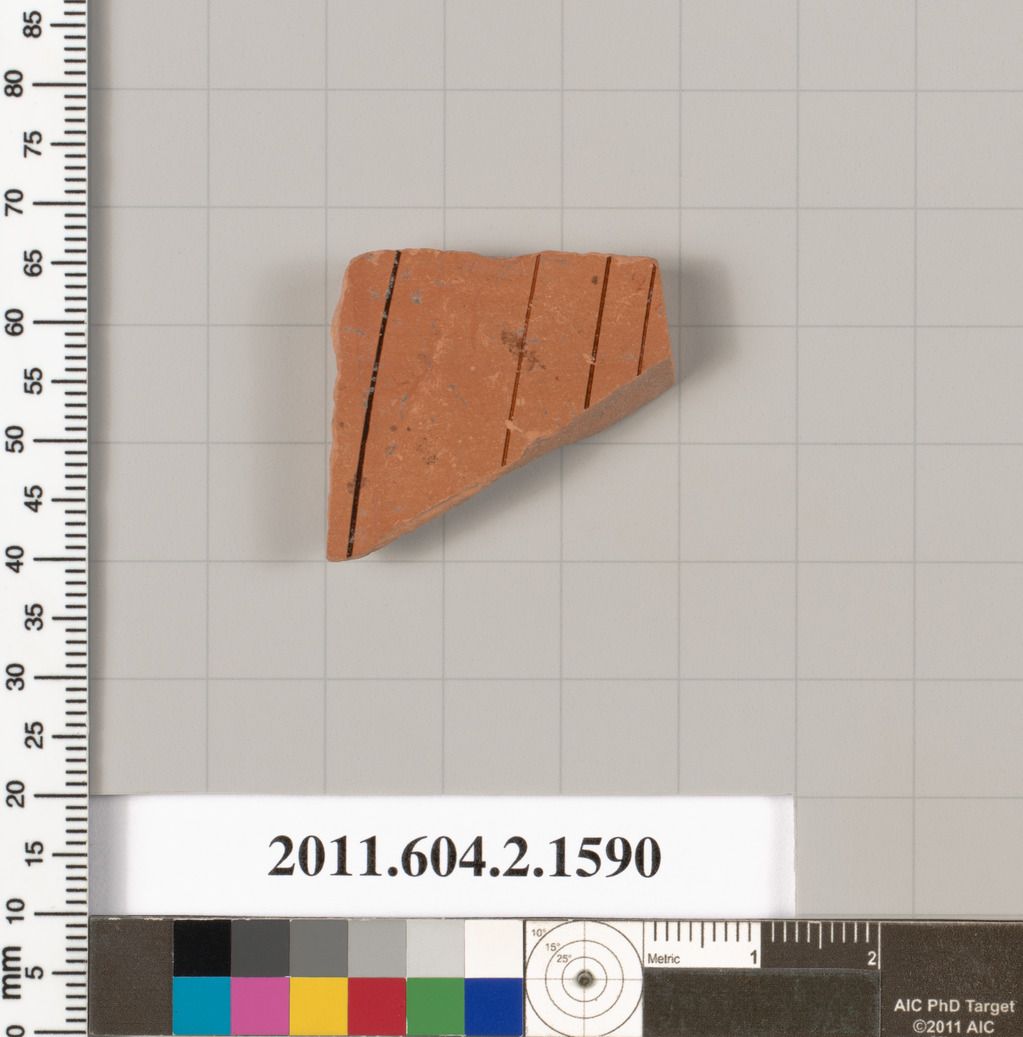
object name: skyphos fragment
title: Terracotta fragment of a skyphos (deep drinking cup)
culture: greek, attic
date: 475-451 BCE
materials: terracotta